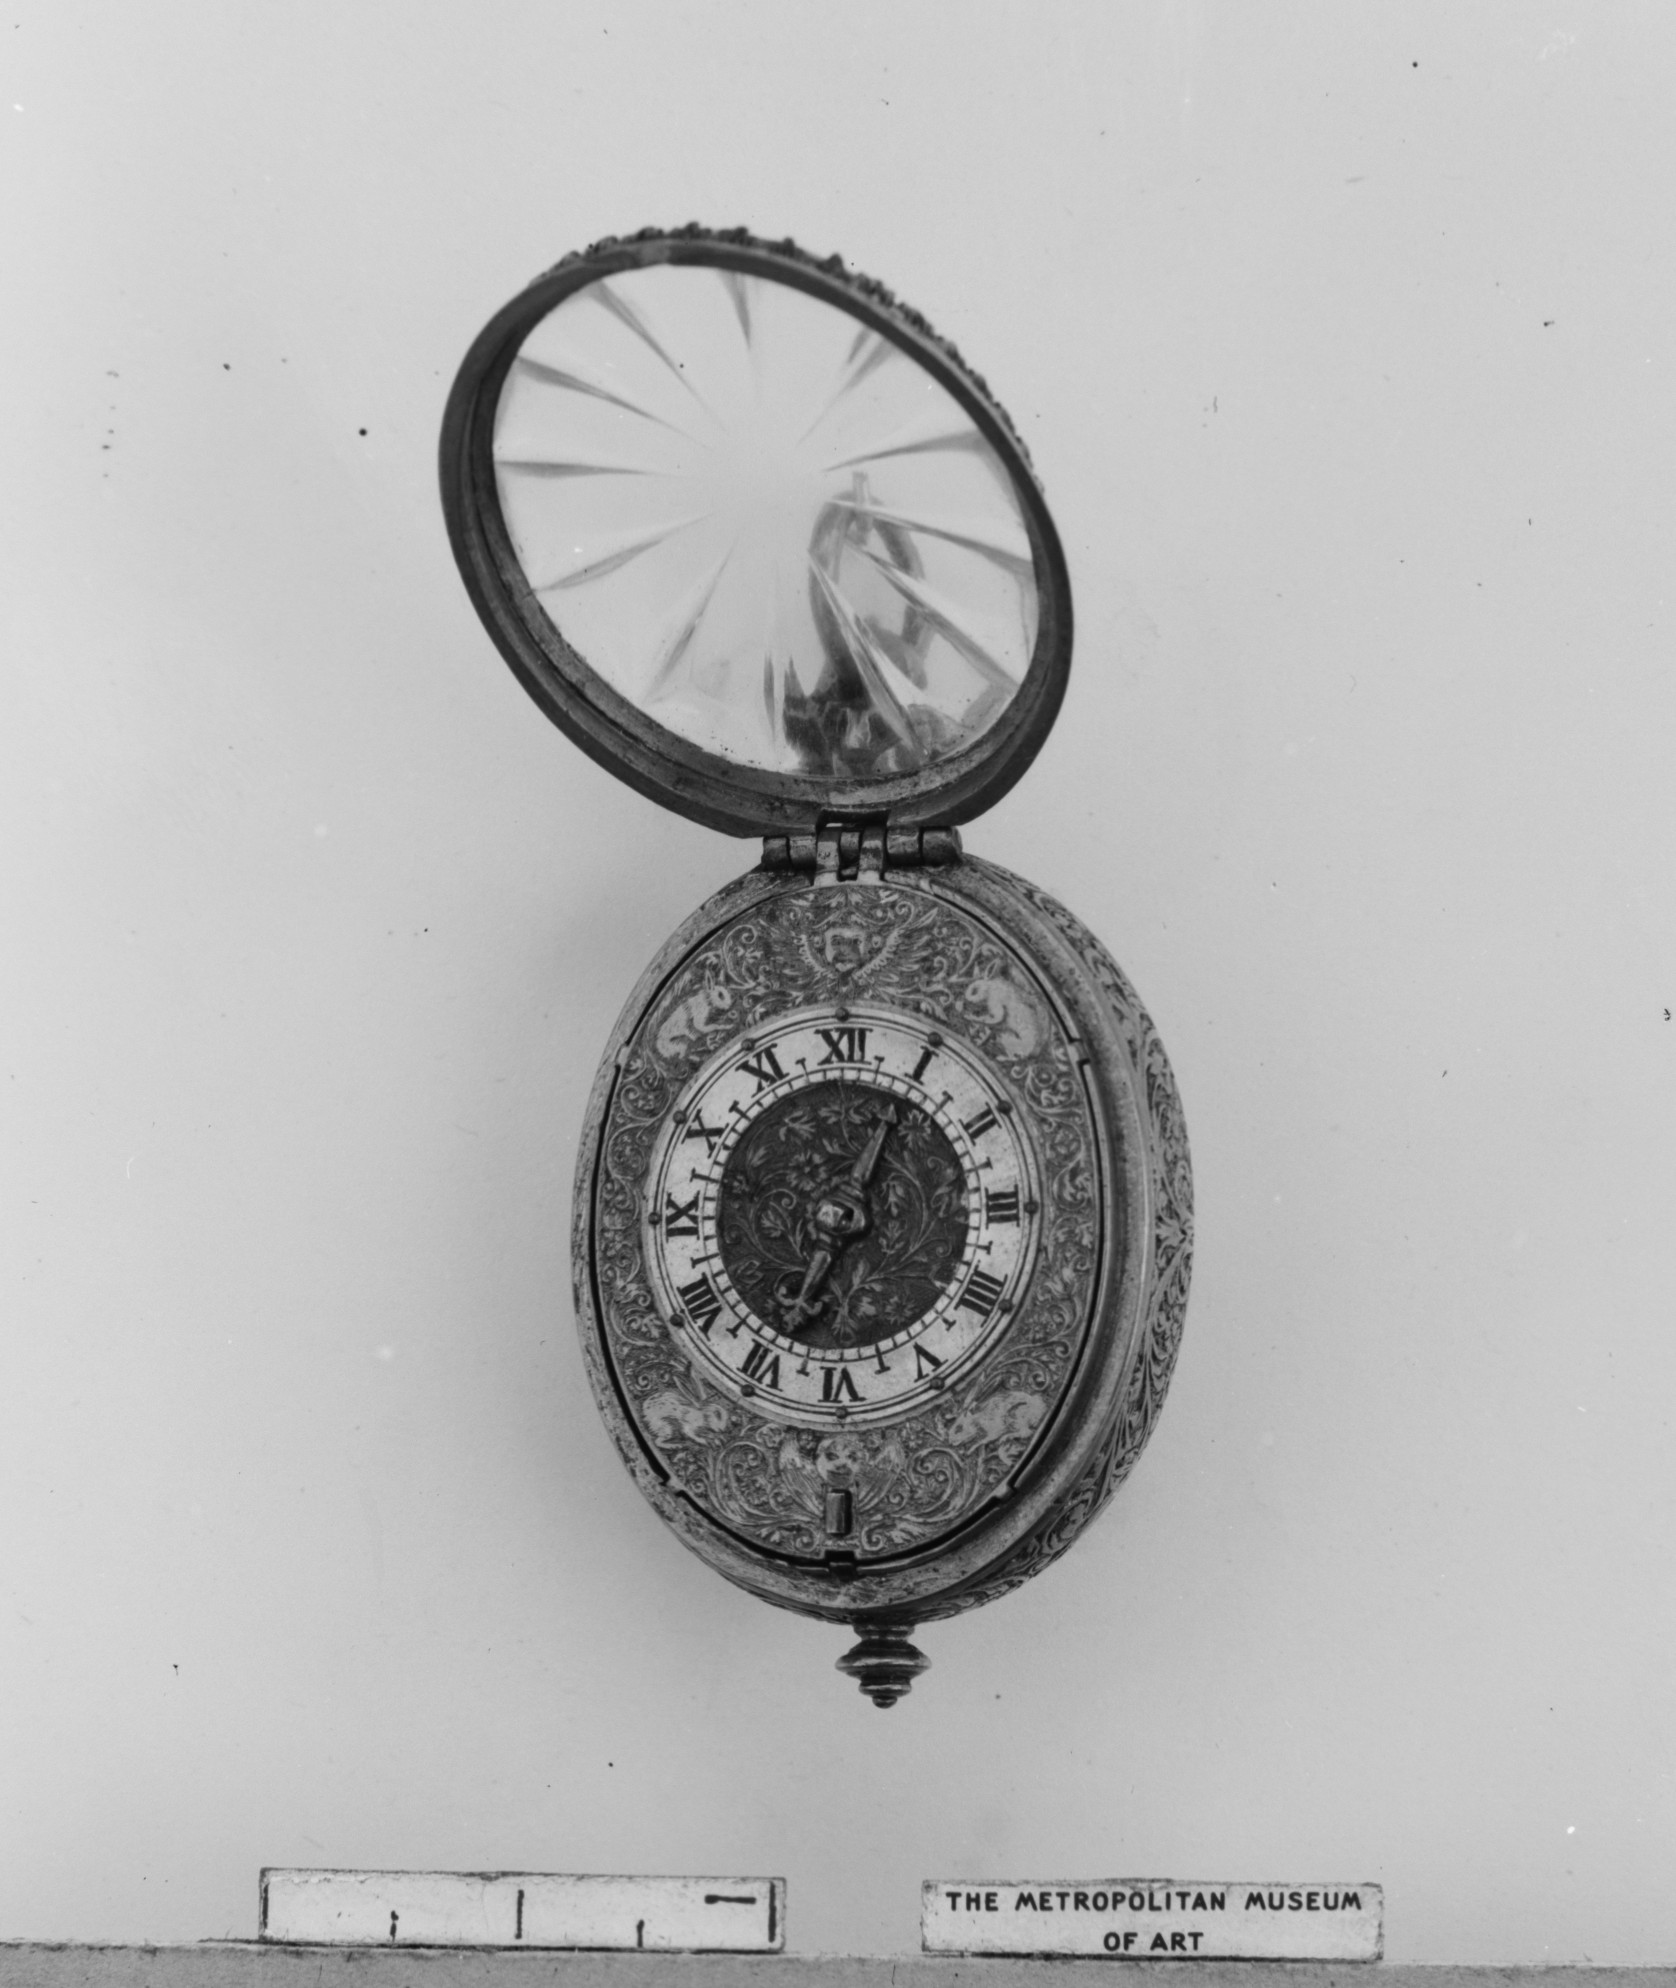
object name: watch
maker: claude du cleron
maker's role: maker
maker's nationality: french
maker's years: 1537-1637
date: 1600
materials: gilt, metal, quartz, silver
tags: rabbits,flowers